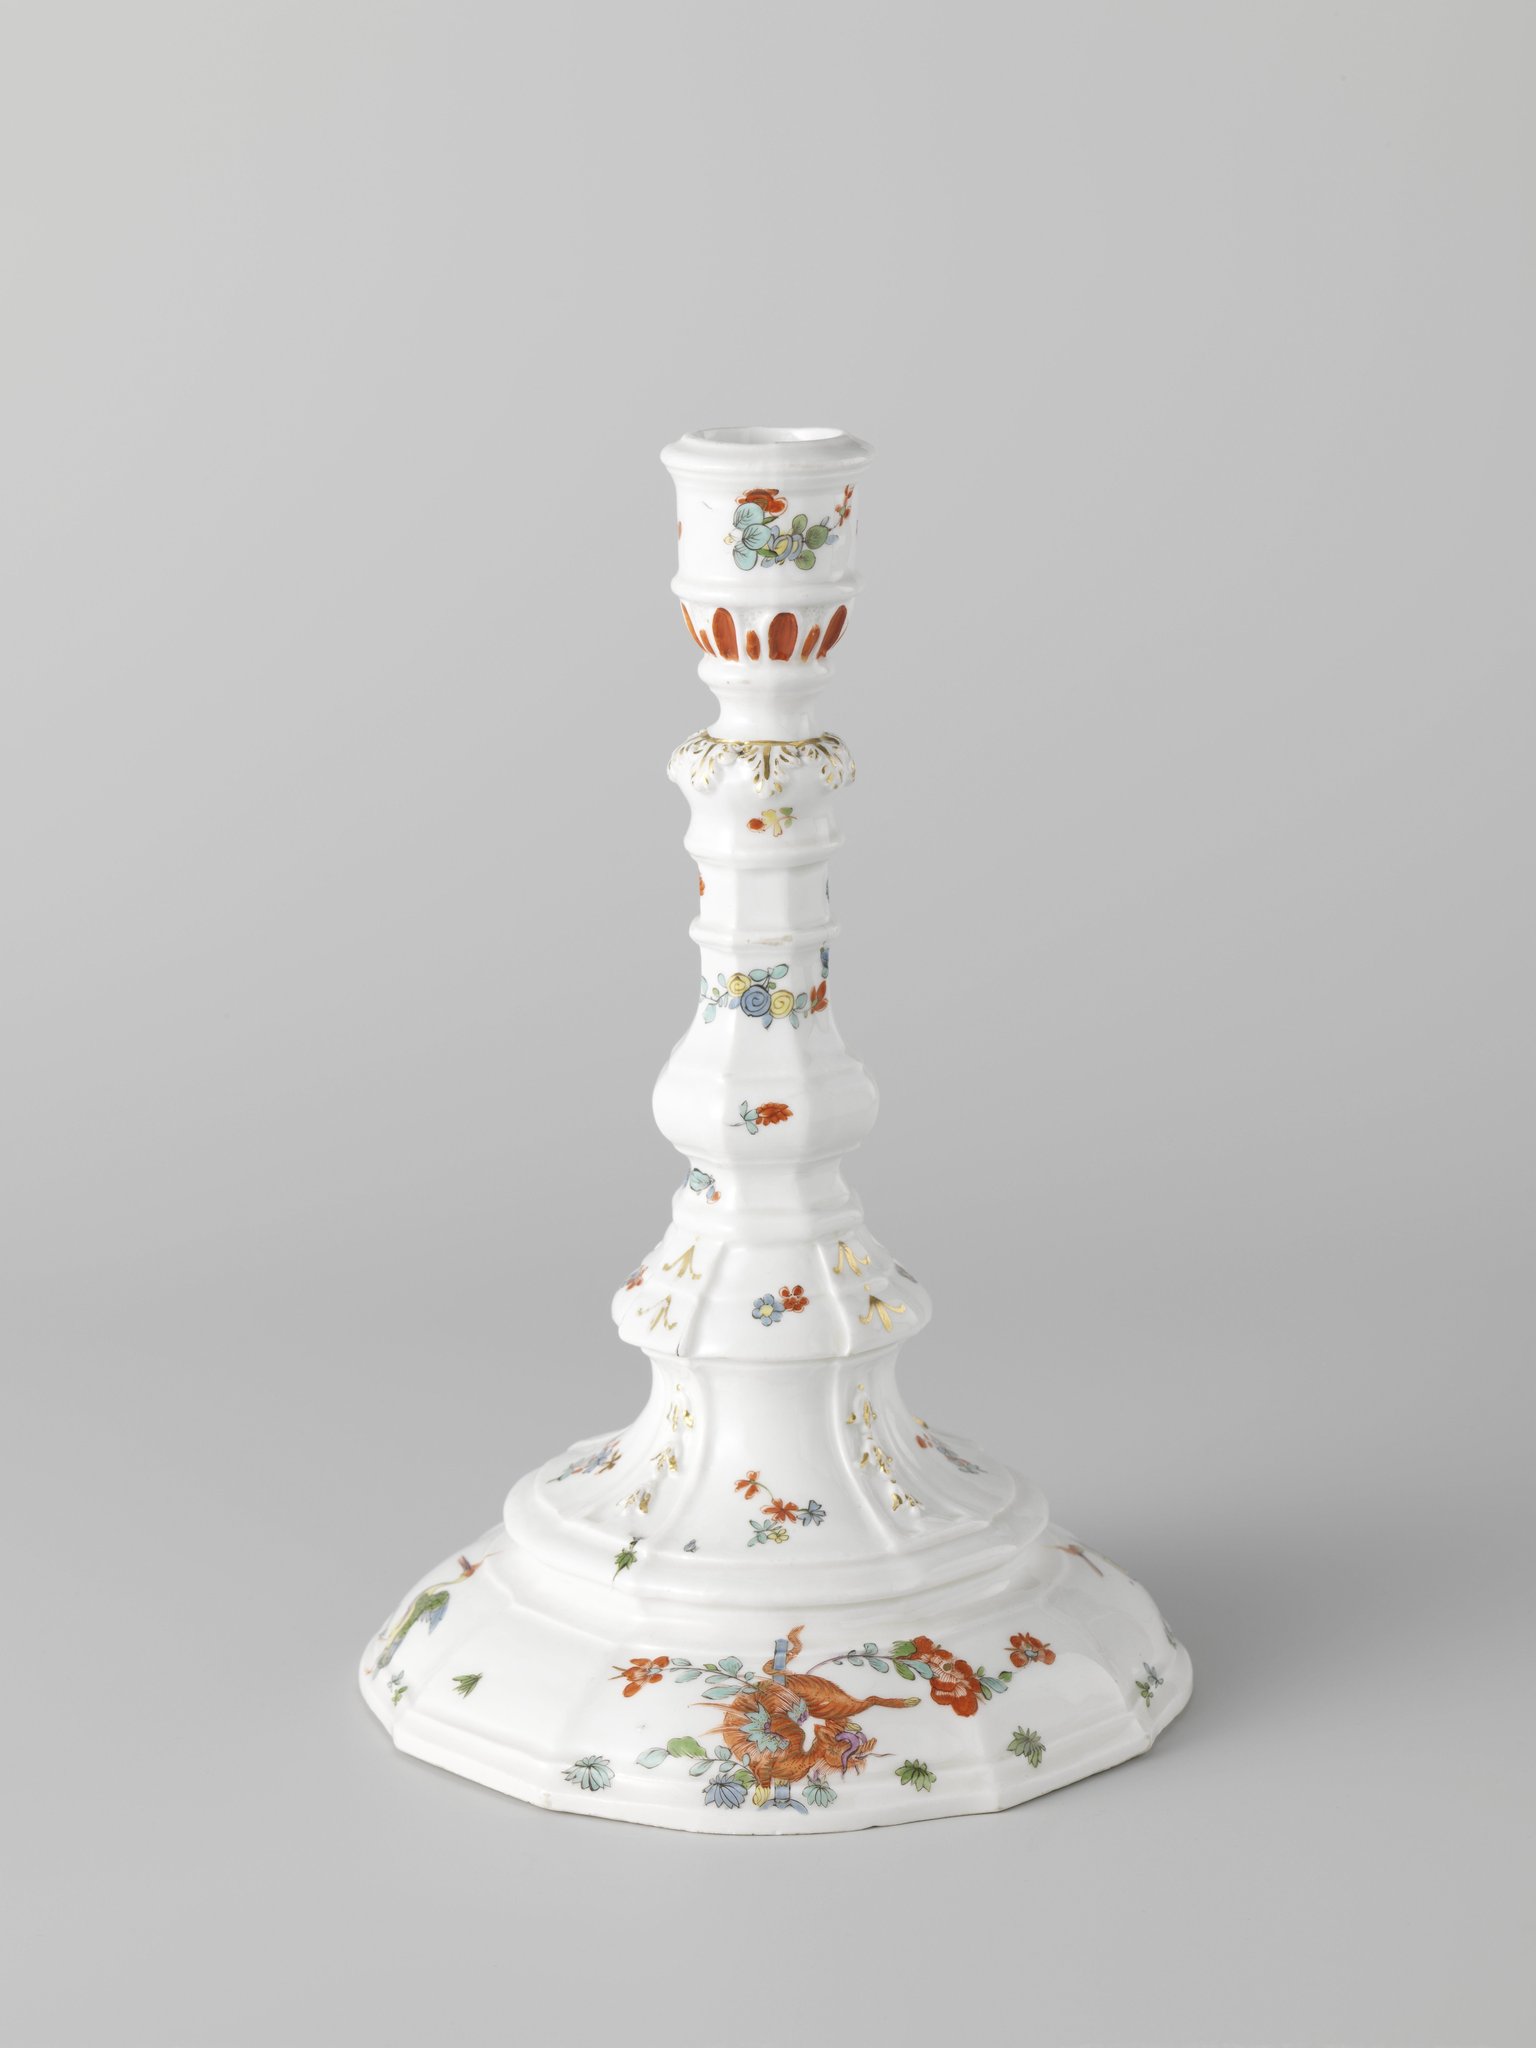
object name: lighting device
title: Kandelaar, veelkleurig beschilderd met een Kakiemon-decor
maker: johann george schlicke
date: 1730-1735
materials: porcelain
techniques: painted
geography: meissen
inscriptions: mold mark, factory mark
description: Two candle sticks. Porcelain. Meissen, c. 1730 - 1735.